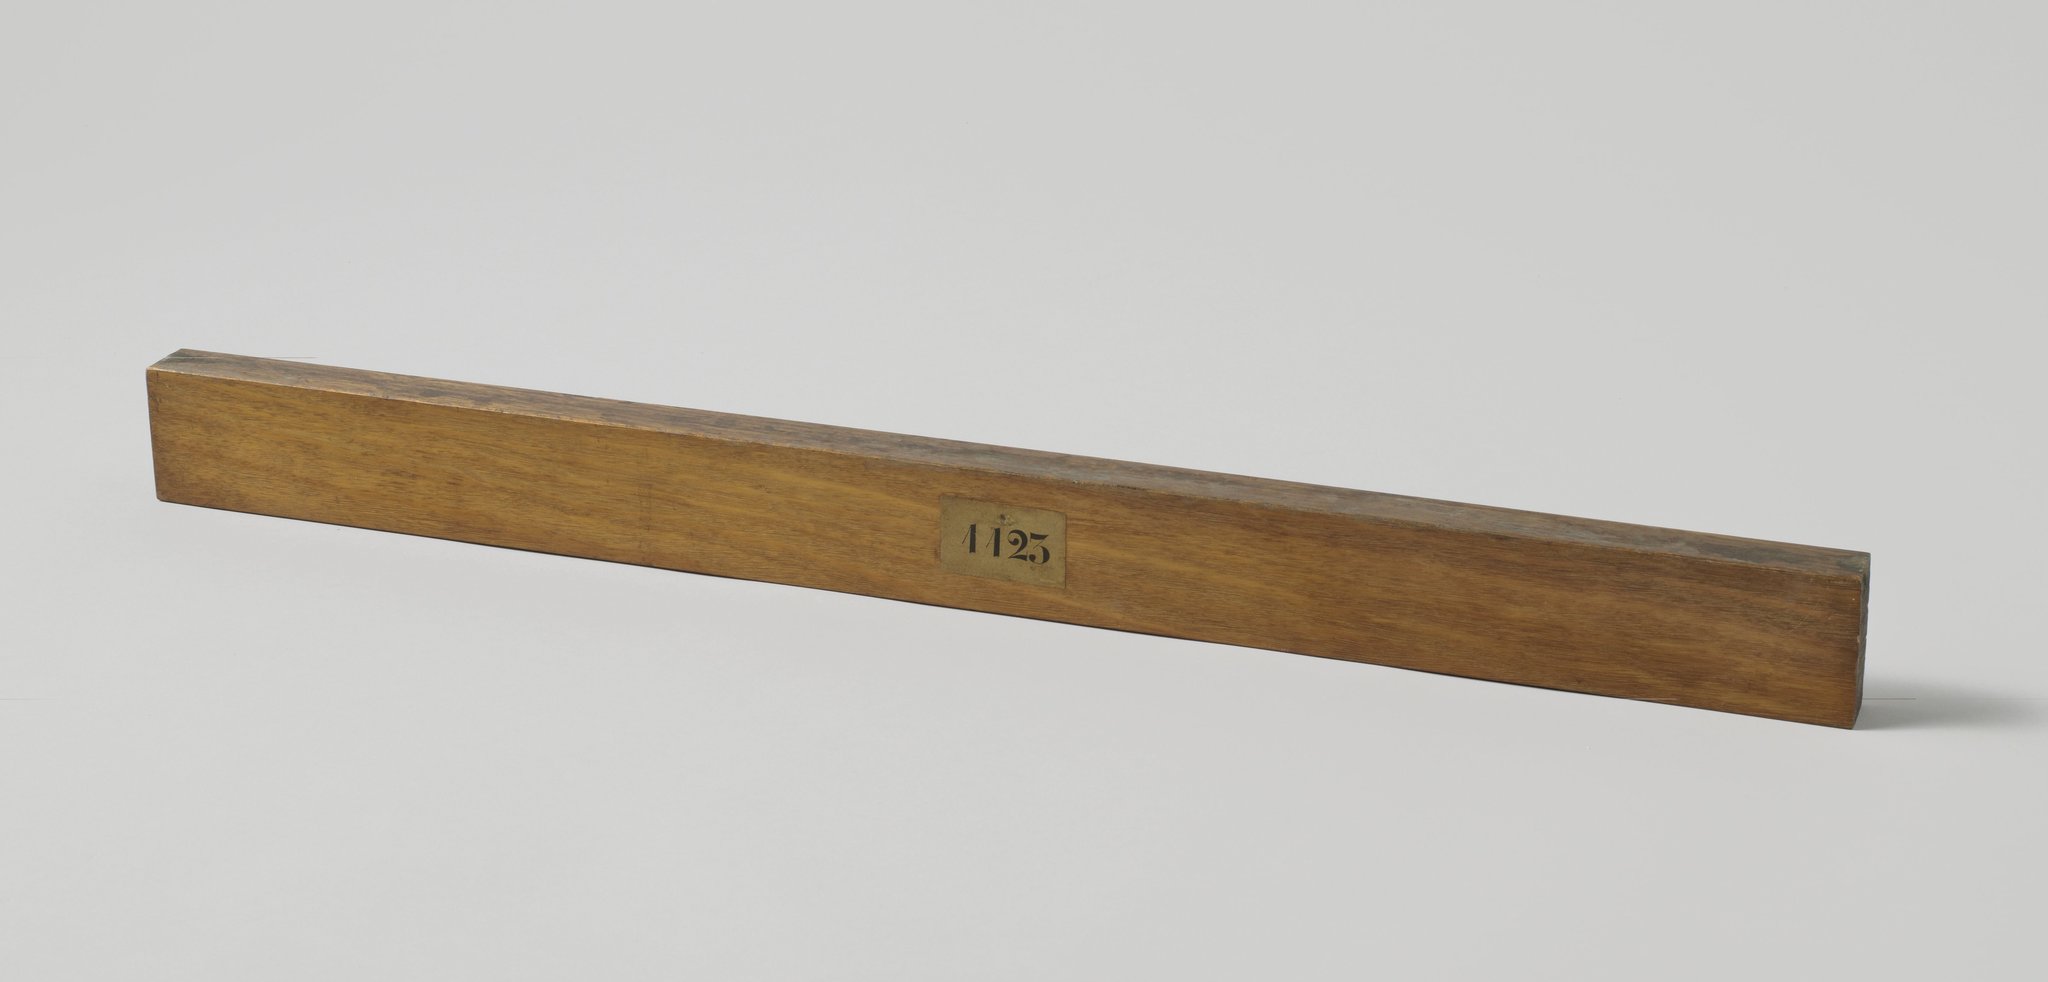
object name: sample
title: Sample of Wood from Tasmania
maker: Anonymous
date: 1862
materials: wood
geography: australia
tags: tasmanië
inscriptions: inscription, in the corner, in ink: ‘Ged. 17 Sept. 1862 n° 42 / Tasmania Blue-gum’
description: Monster van Tasmania blue gum (Eucalyptus spec.).